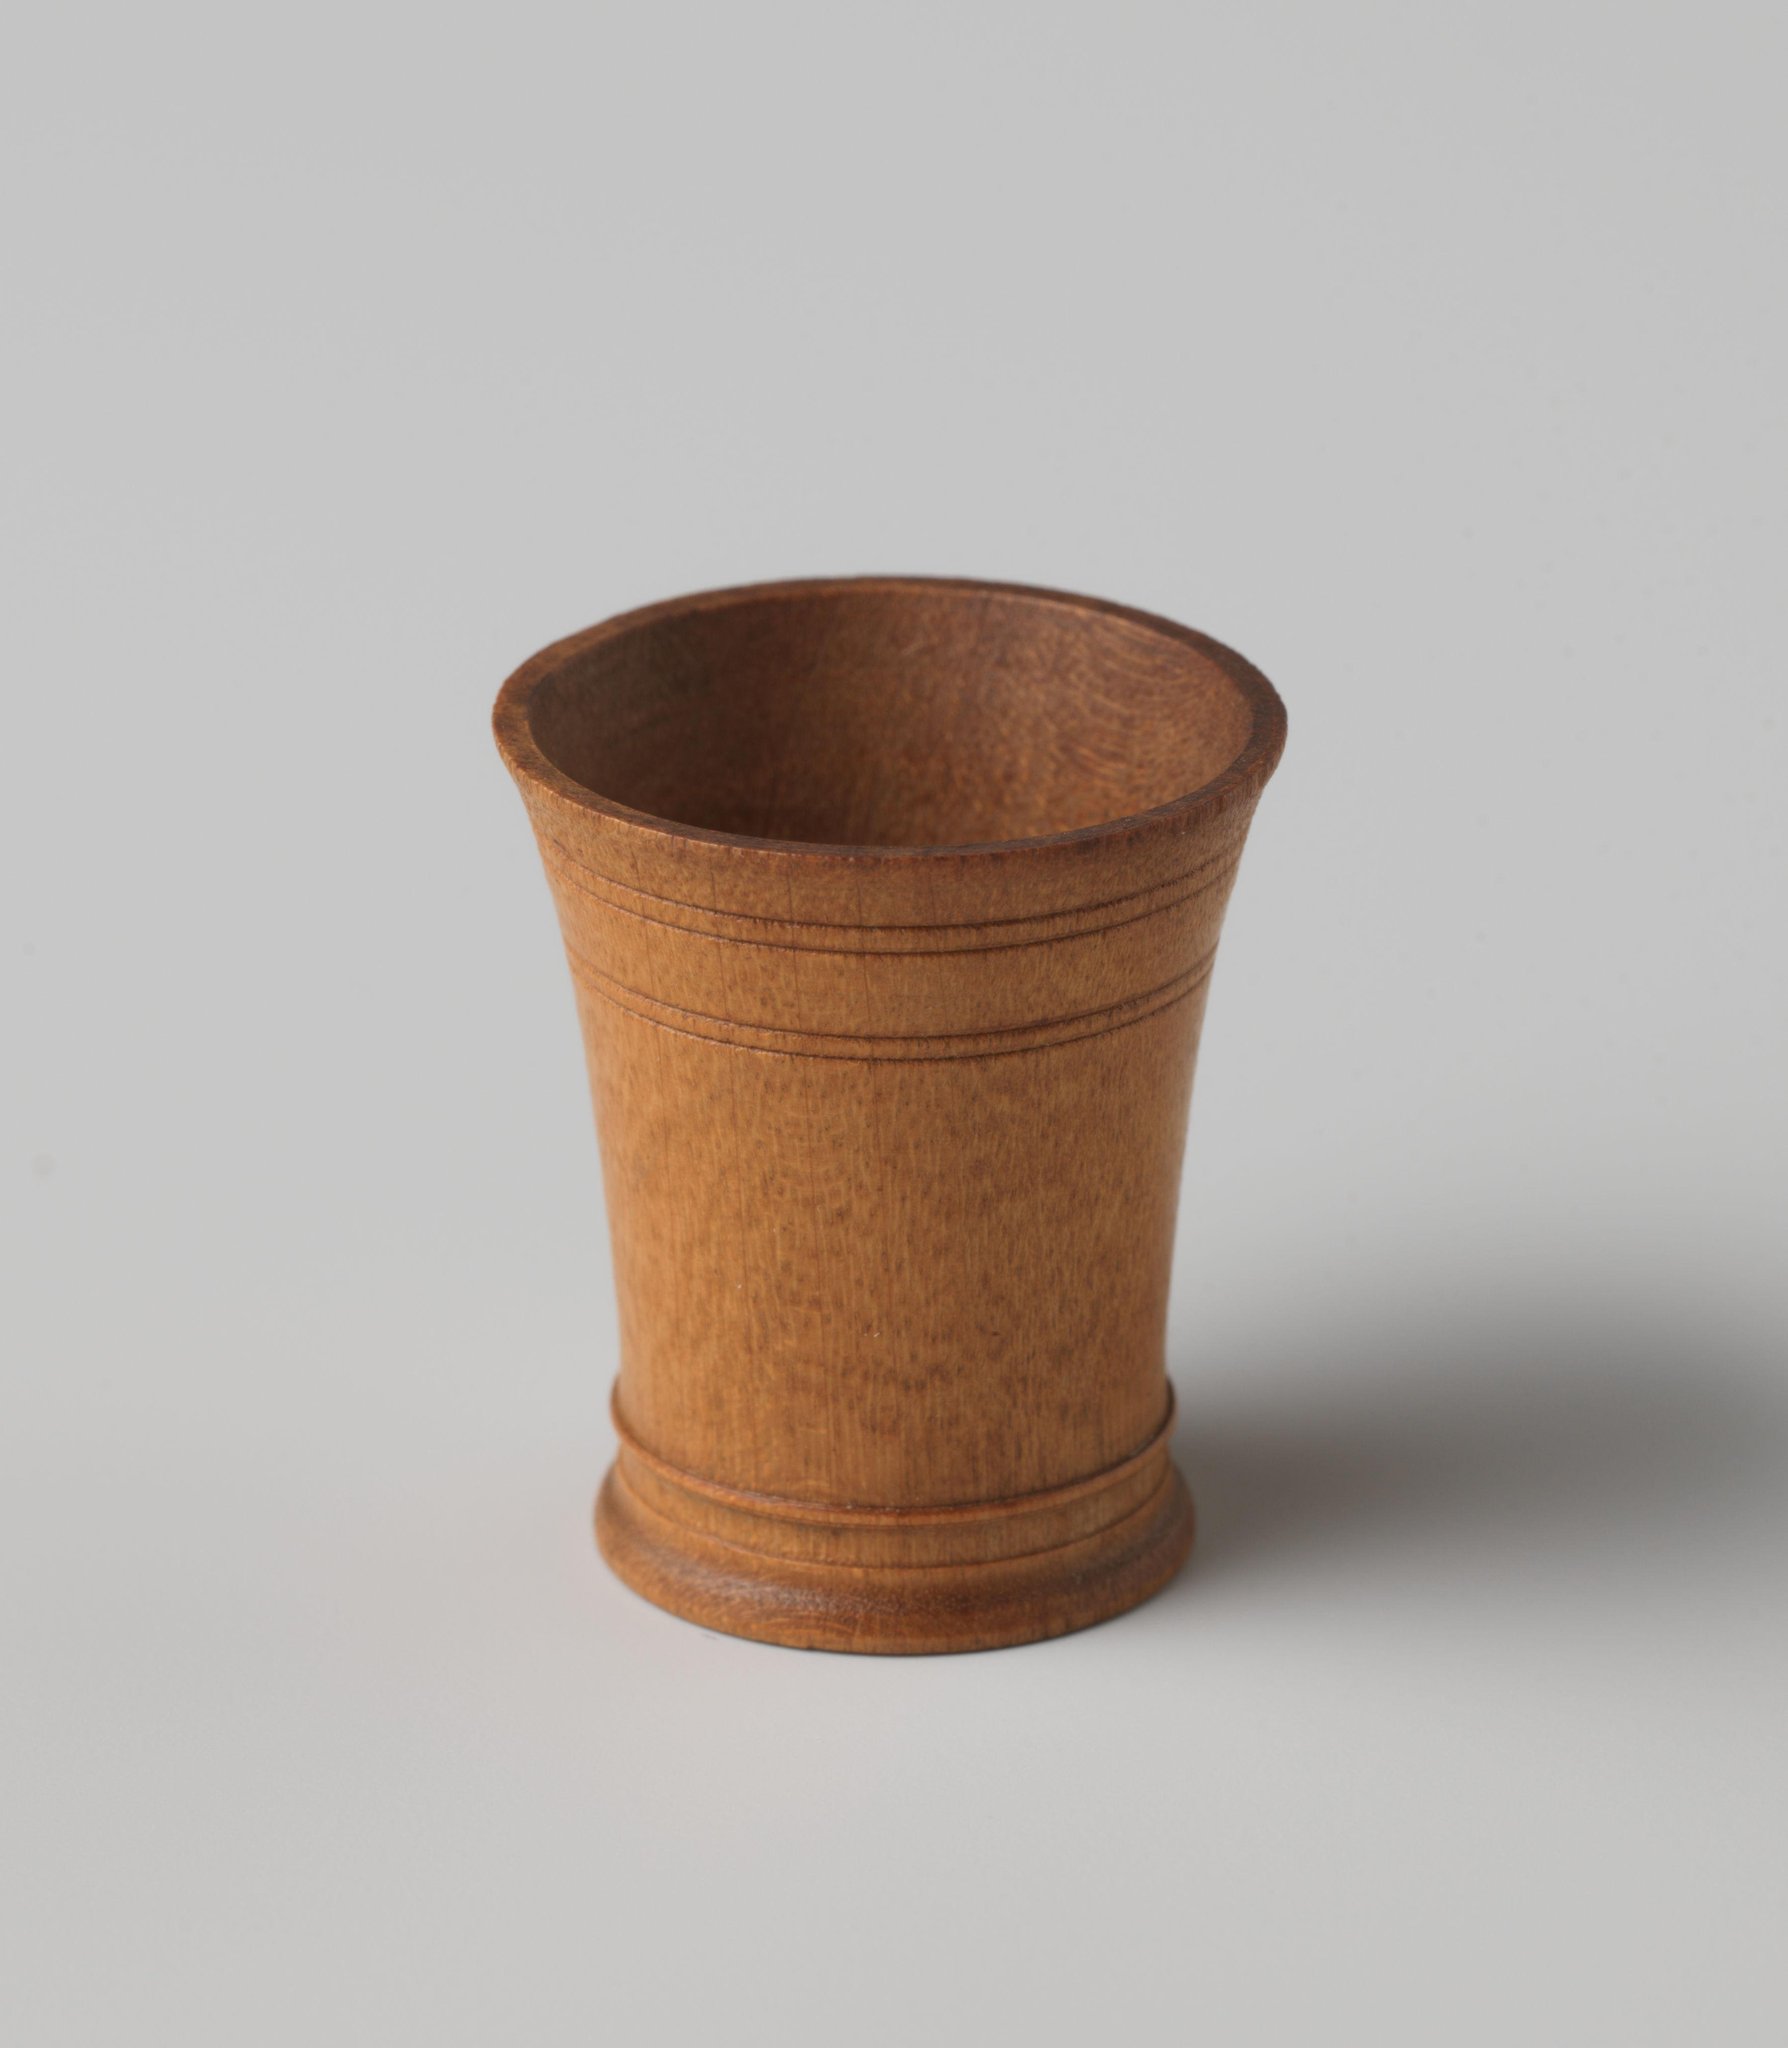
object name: miniature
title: Beker met profielrand en twee groefranden, gedraaid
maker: Anonymous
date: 1675-1700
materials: wood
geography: amsterdam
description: Een beker van gedraaid esdoornhout met onder één profielrand en boven twee dubbele groefranden.